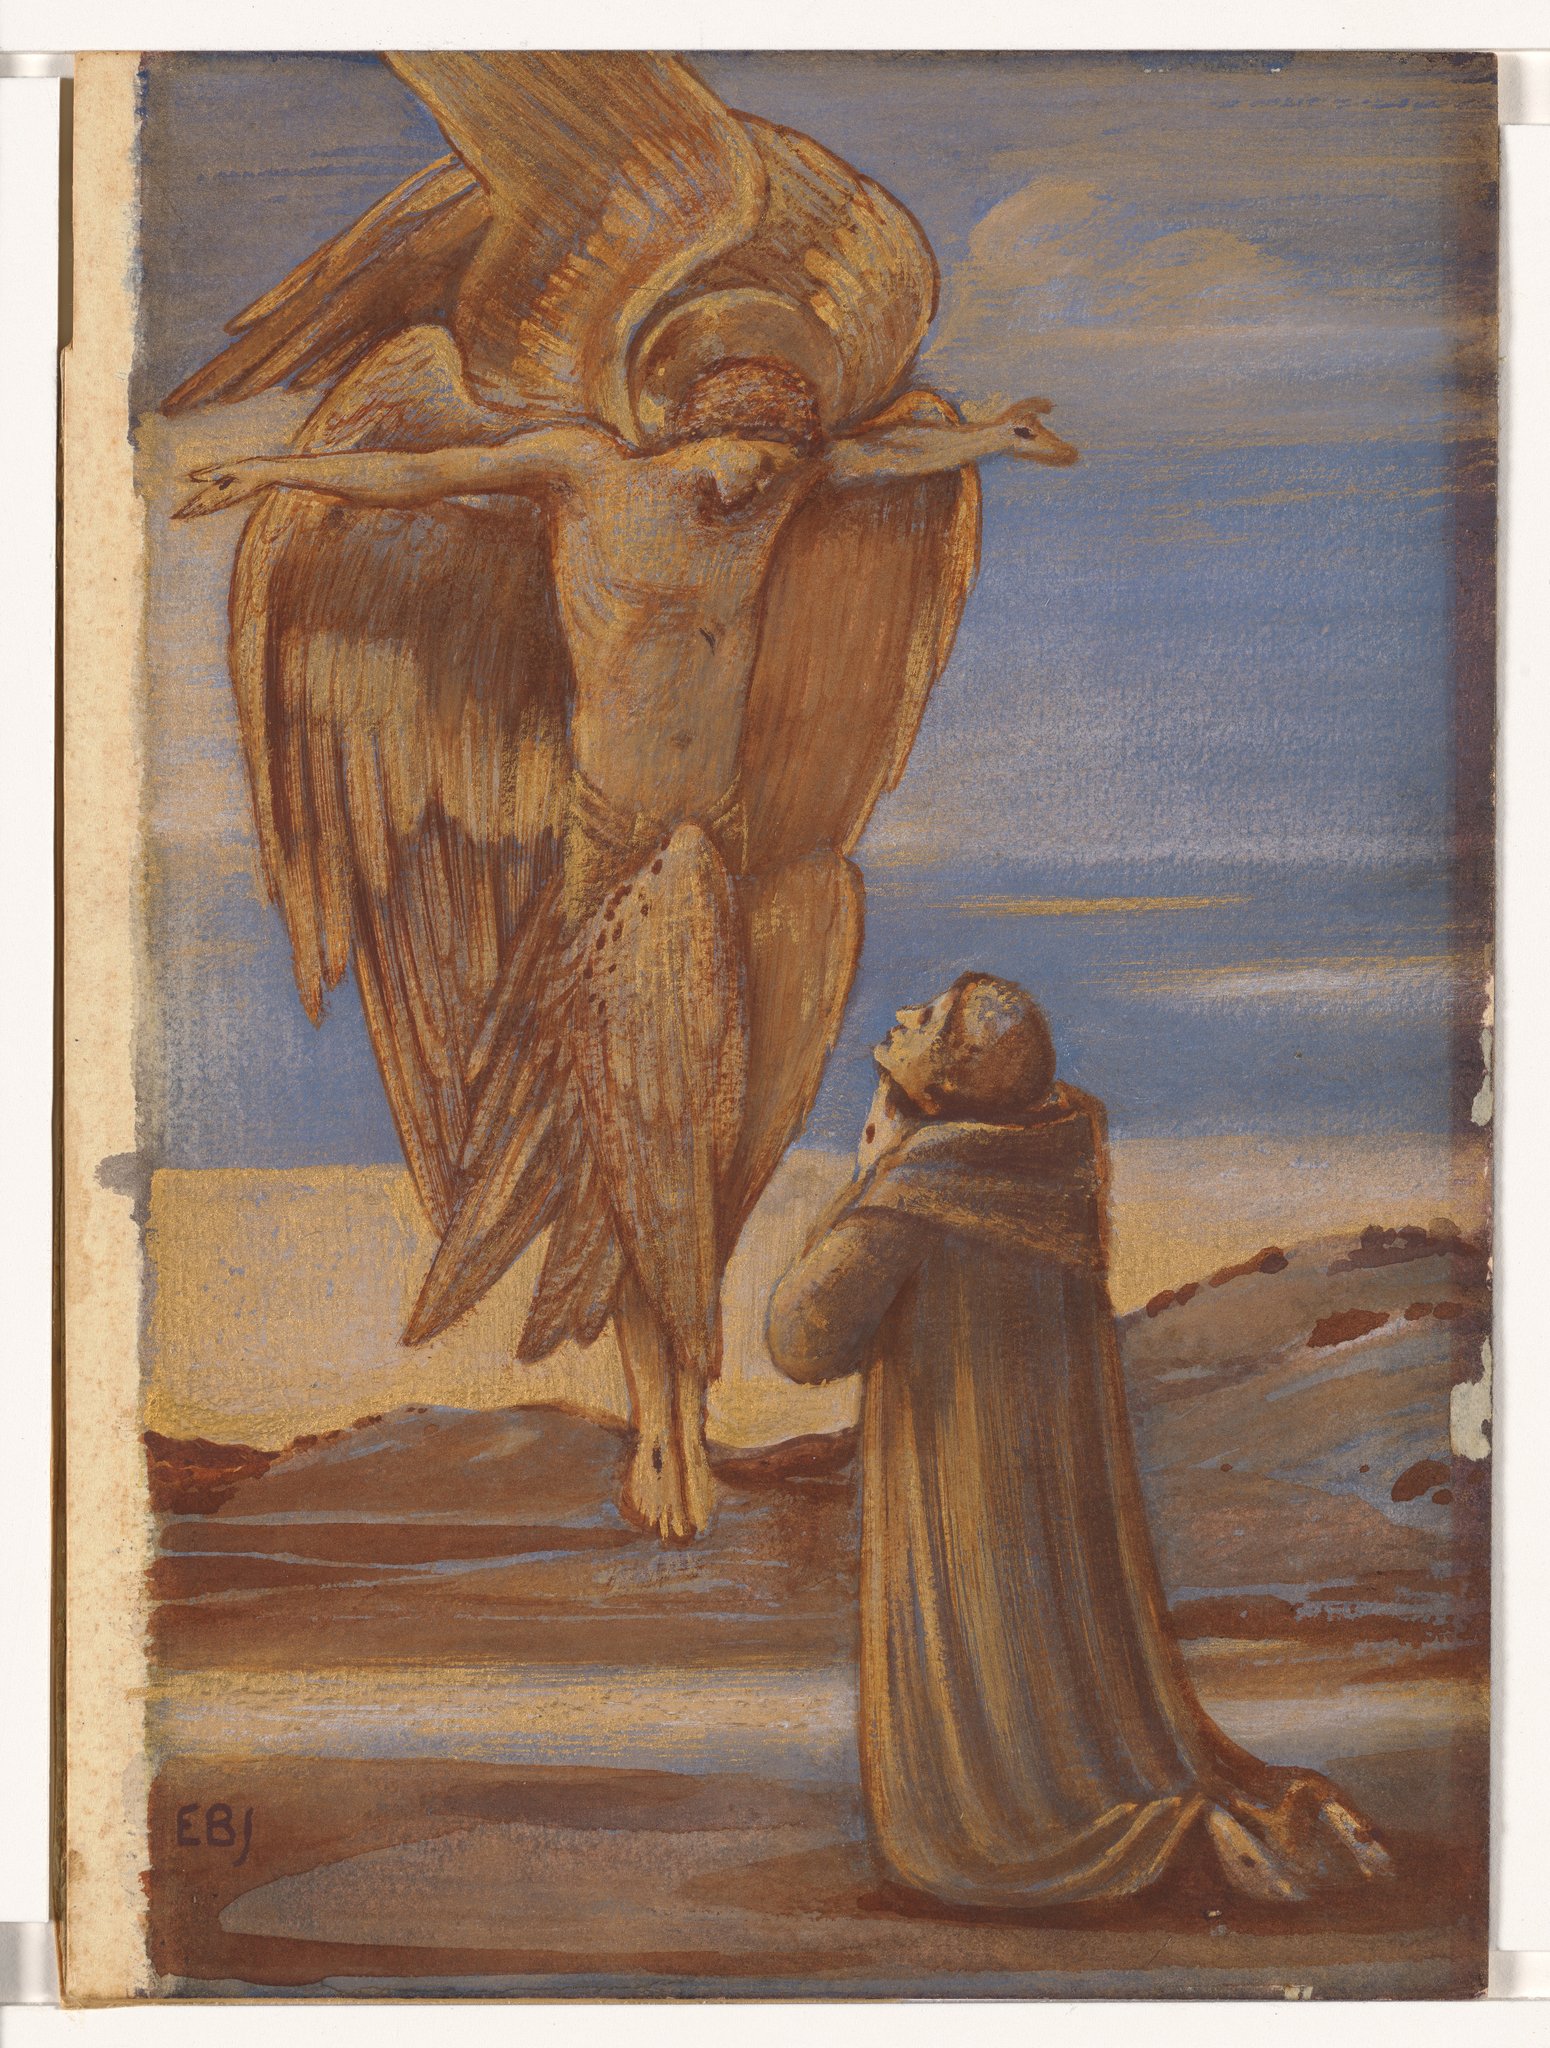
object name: drawing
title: The Vision of St. Francis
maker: sir edward burne-jones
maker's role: artist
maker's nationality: british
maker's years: 1833-1898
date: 1887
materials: gold, gouache, pigment, watercolor